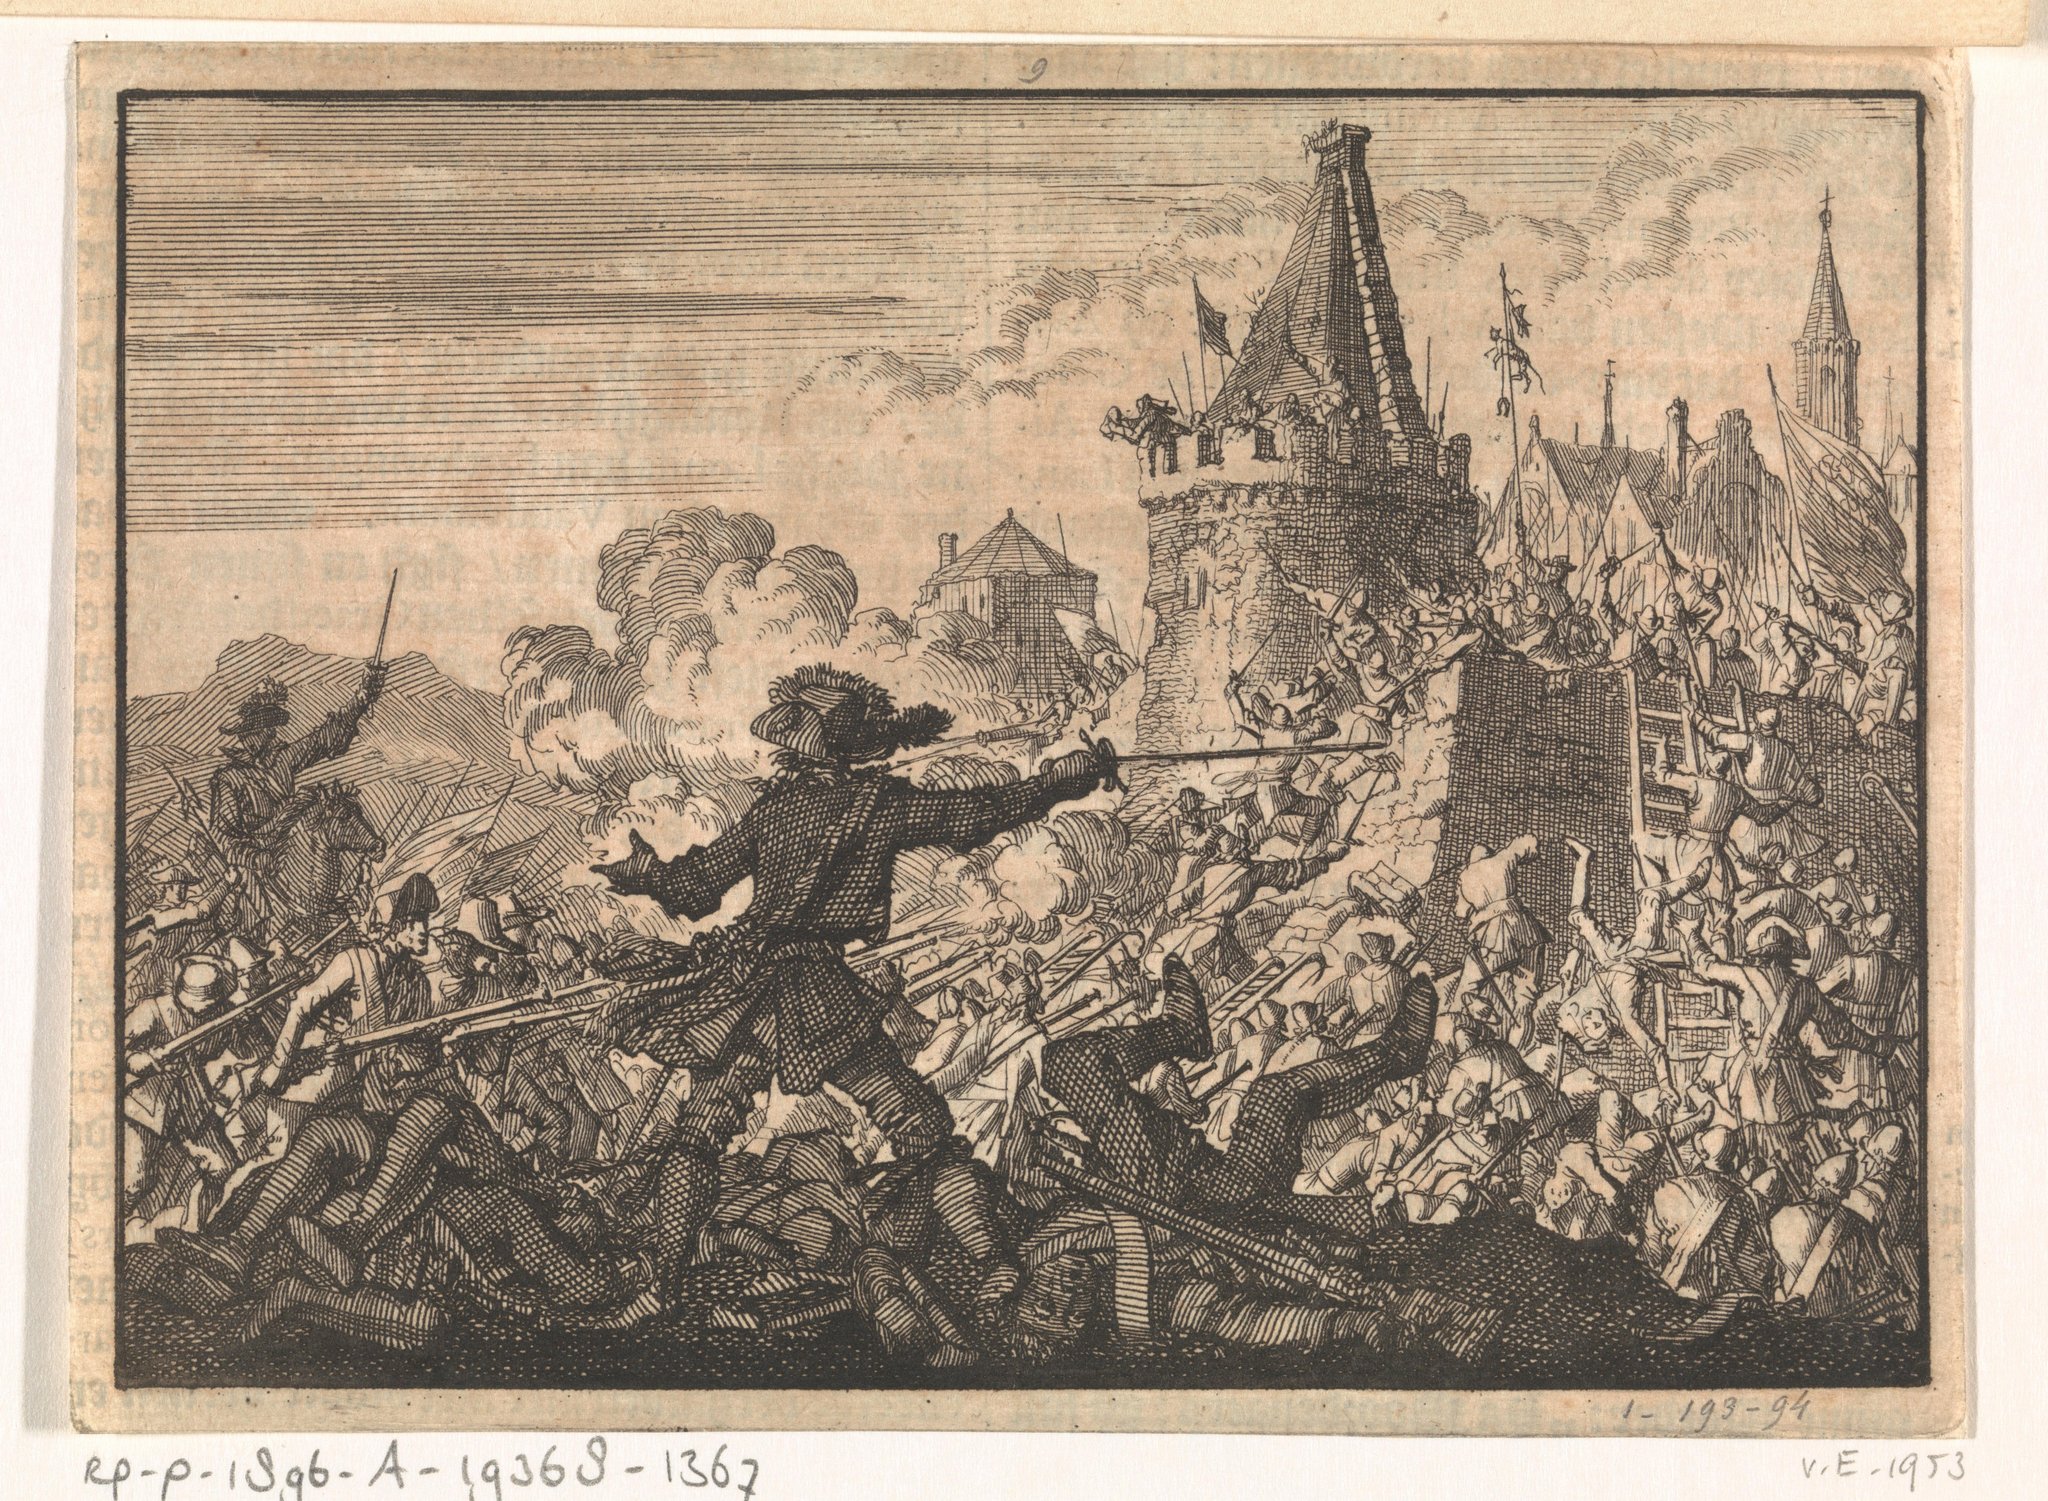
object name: book illustration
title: Afgeslagen bestorming van de muren van Livron, door de Hugenoten verdedigd, 1574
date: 1698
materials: paper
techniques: etching, letterpress printing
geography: amsterdam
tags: attack ~ siege, city-walls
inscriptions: collector's mark: Lugt 2228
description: Illustratie uit: Gottfried, Johann Ludwig. Historische kronyck; vervattende een (...) beschrijvingh der aldergedenckwaerdigste geschiedenissen des weerelds, van den aenvangh der scheppingh tot (...) 1576 (2 delen). Leiden: Pieter van der Aa, 1698, dl. I, p. 193.